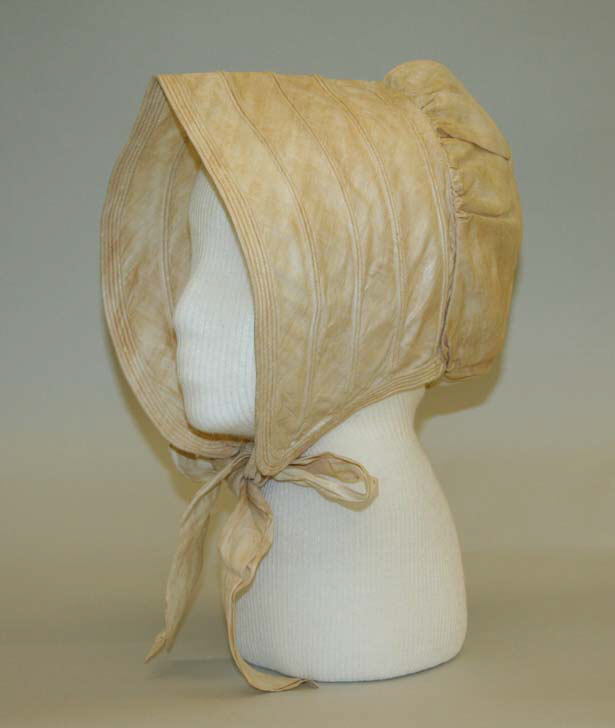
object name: sunbonnet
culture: indian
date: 1870